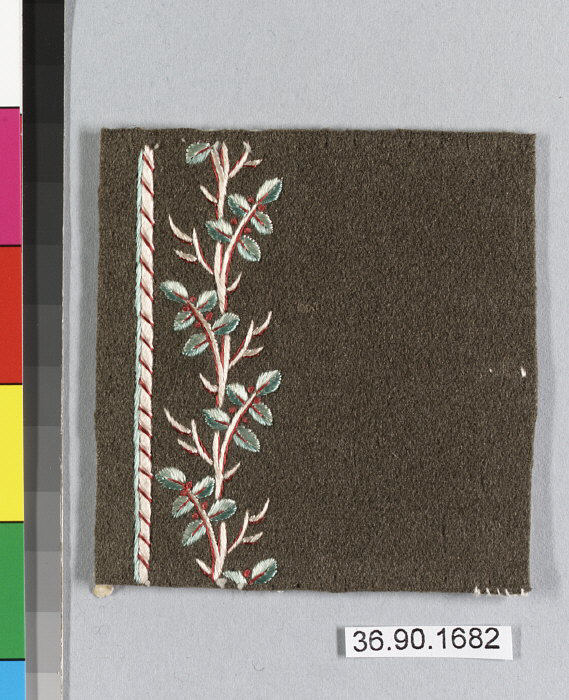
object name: sample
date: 1801-1833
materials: felt, silk